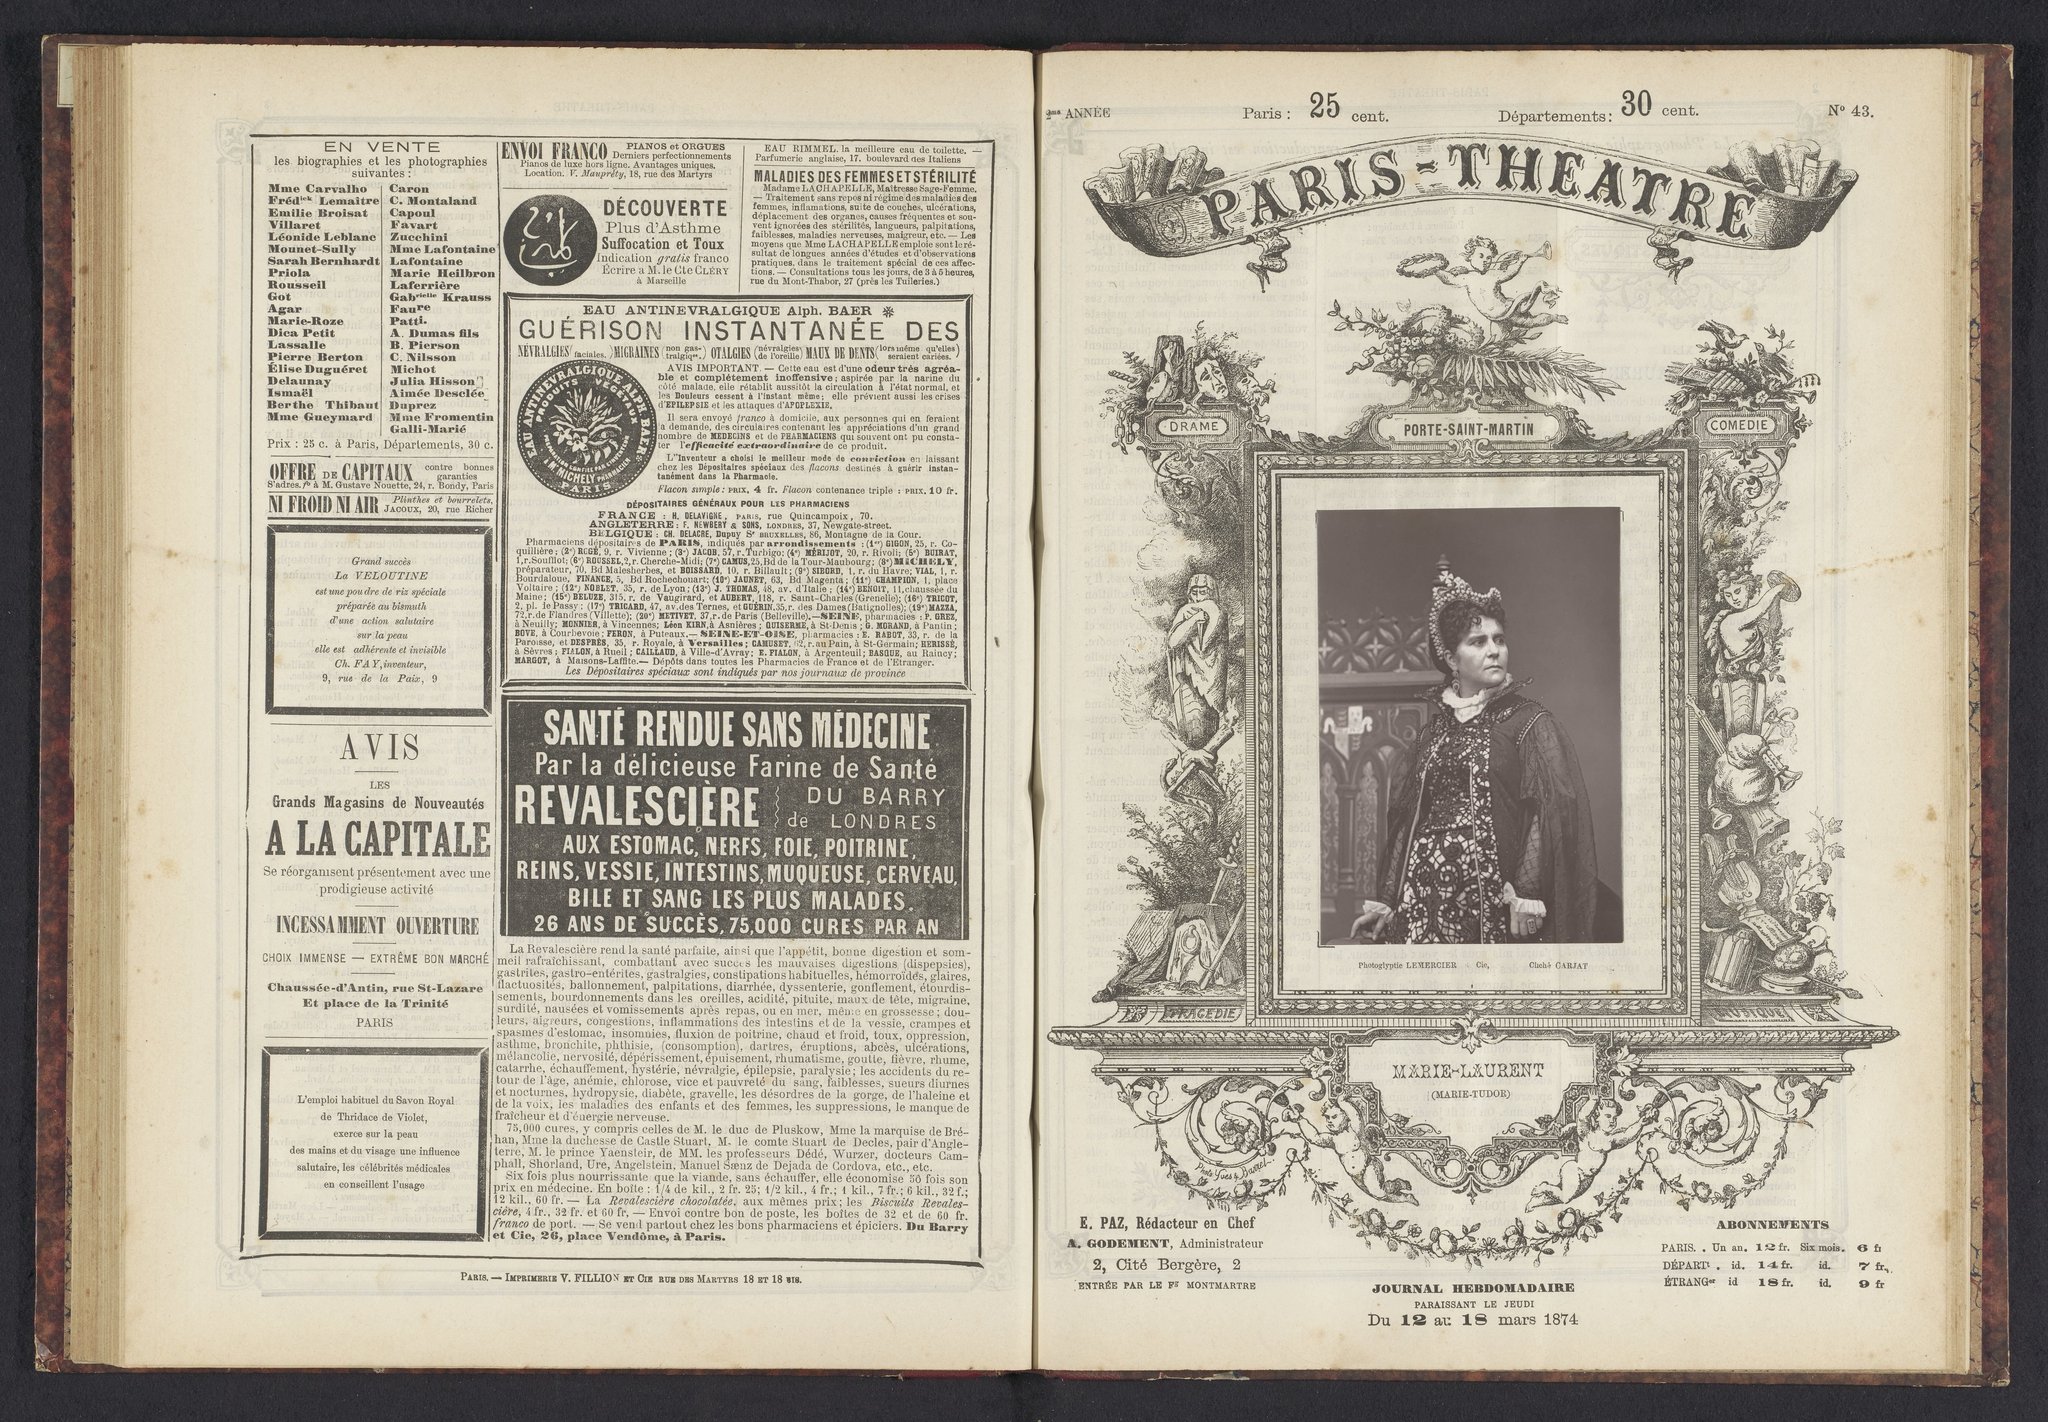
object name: page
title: Marie-Laurent (Marie-Tudor)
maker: étienne carjat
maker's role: draughtsman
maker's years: 1828-1906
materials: paper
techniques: woodburytype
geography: france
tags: portrait of actor, actress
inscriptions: number: ‘No 43.’, inscription: ‘Journal hebdomadaire paraissant le Jeudi Du 12 au 18 mars 1874’